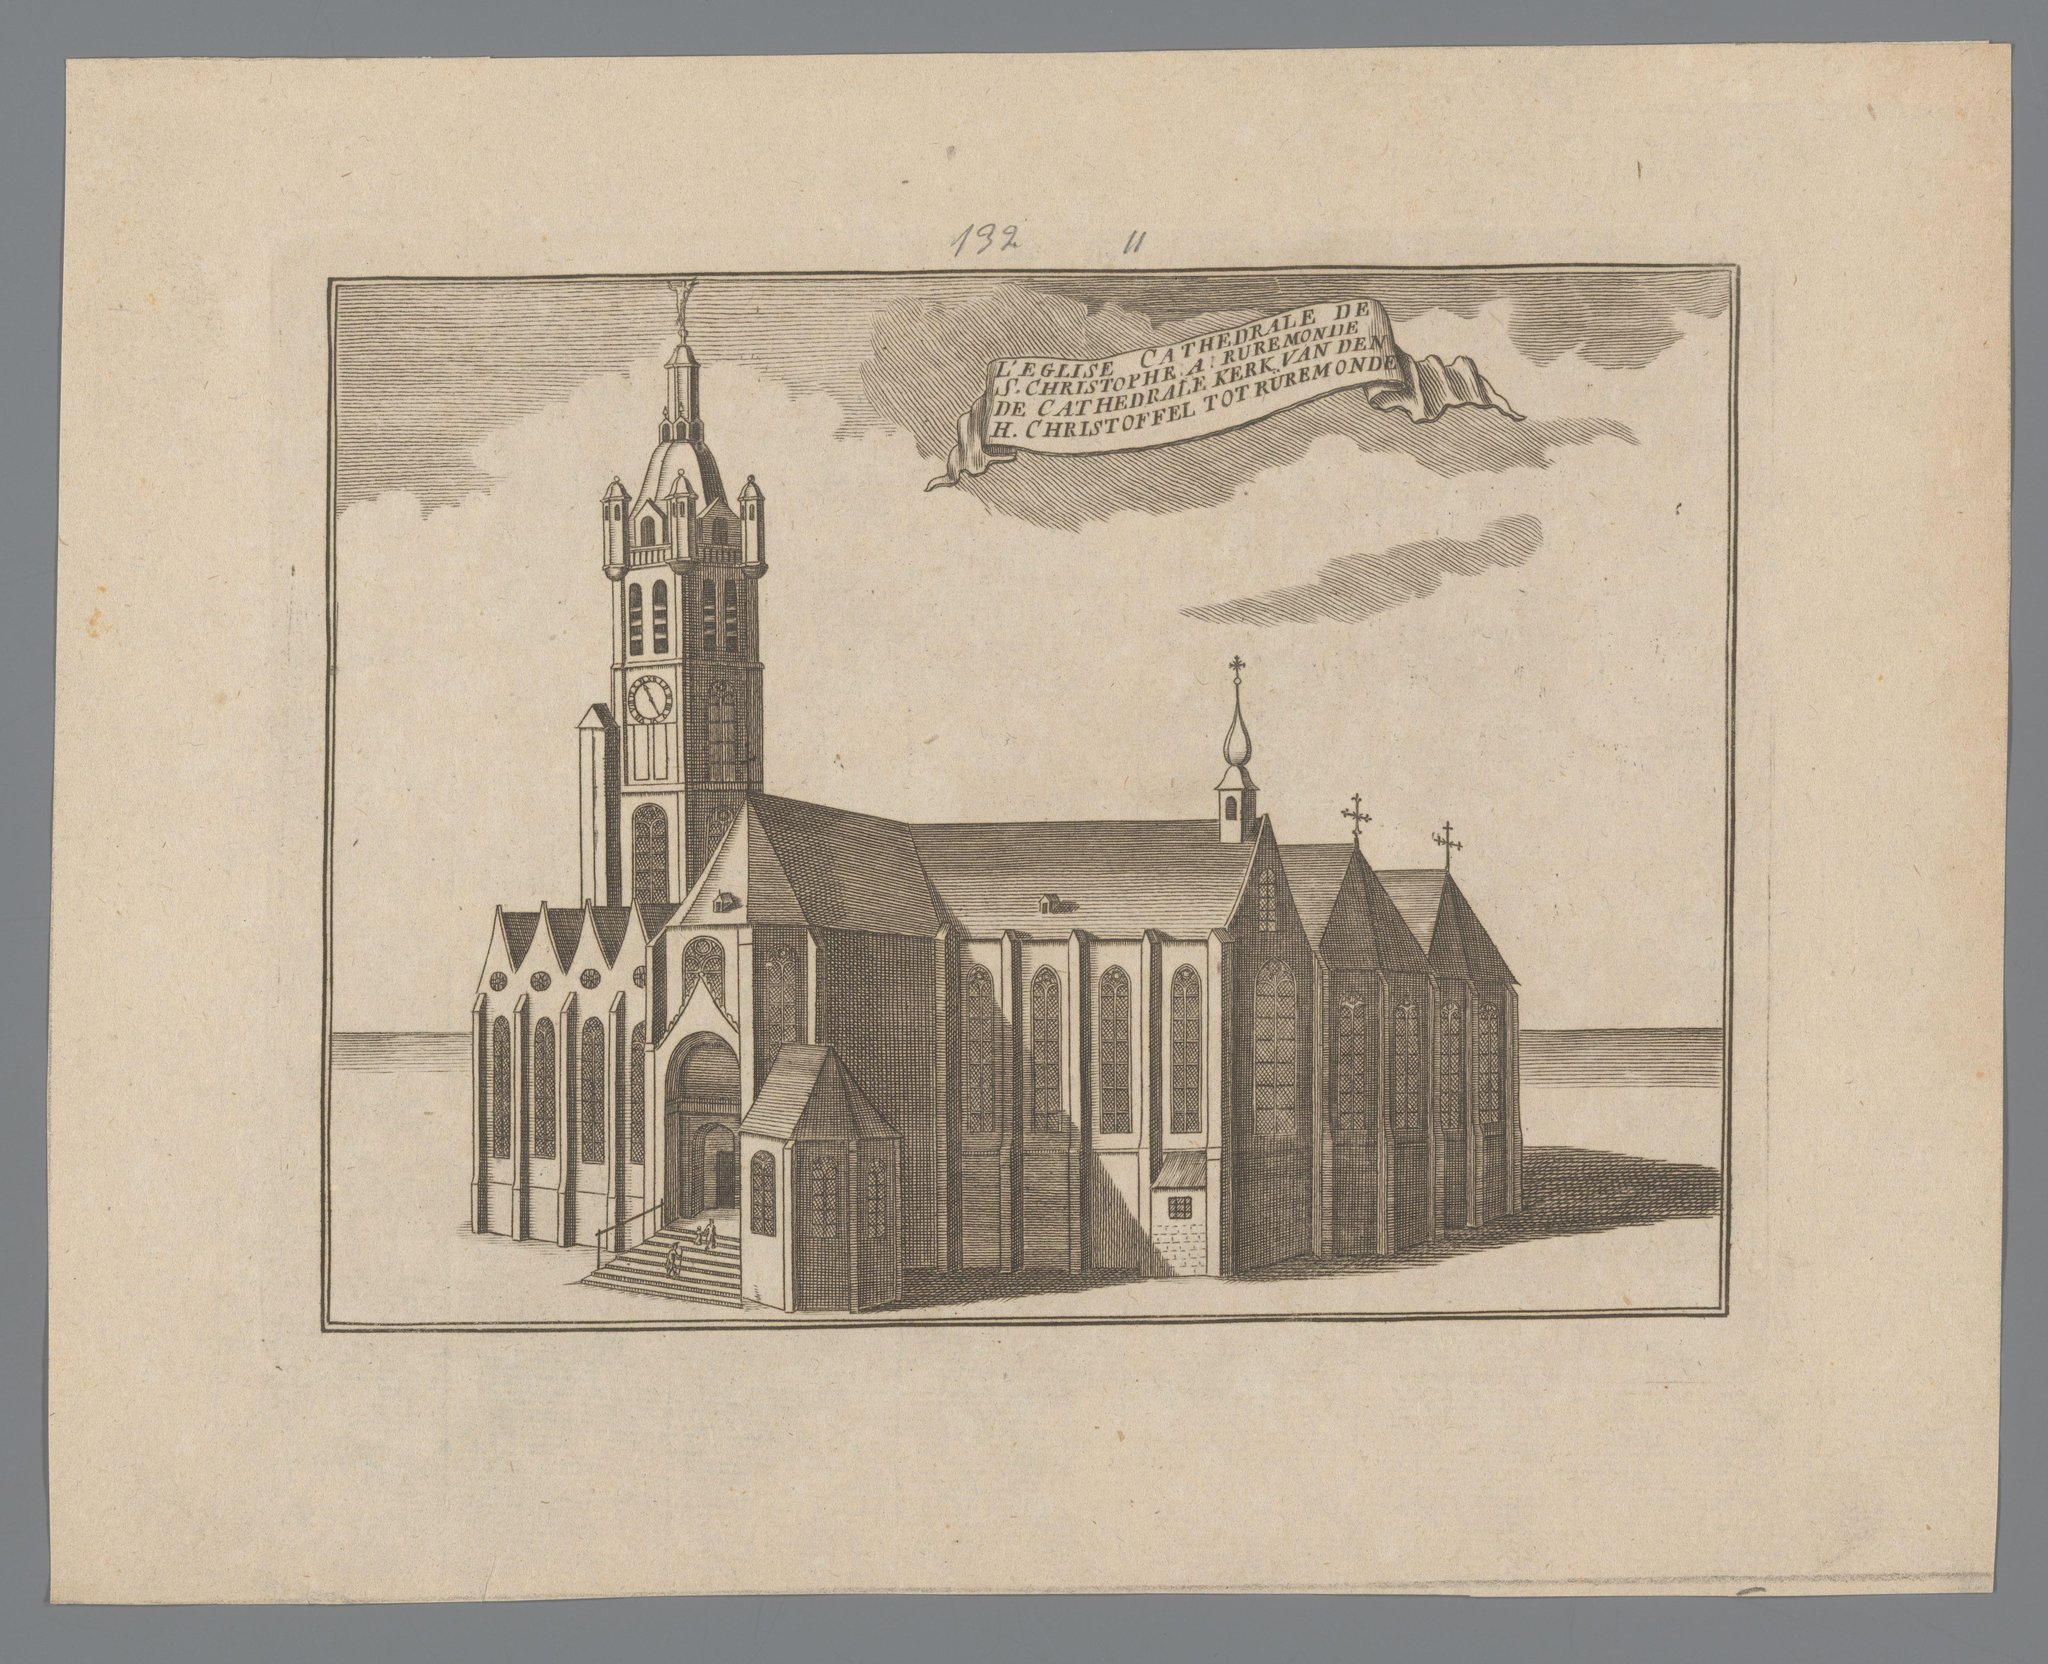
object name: print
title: Gezicht op de Sint-Christoffelkathedraal te Roermond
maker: jacobus harrewijn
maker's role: print maker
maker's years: 1660-1740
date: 1700-1750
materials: paper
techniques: etching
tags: church (exterior)